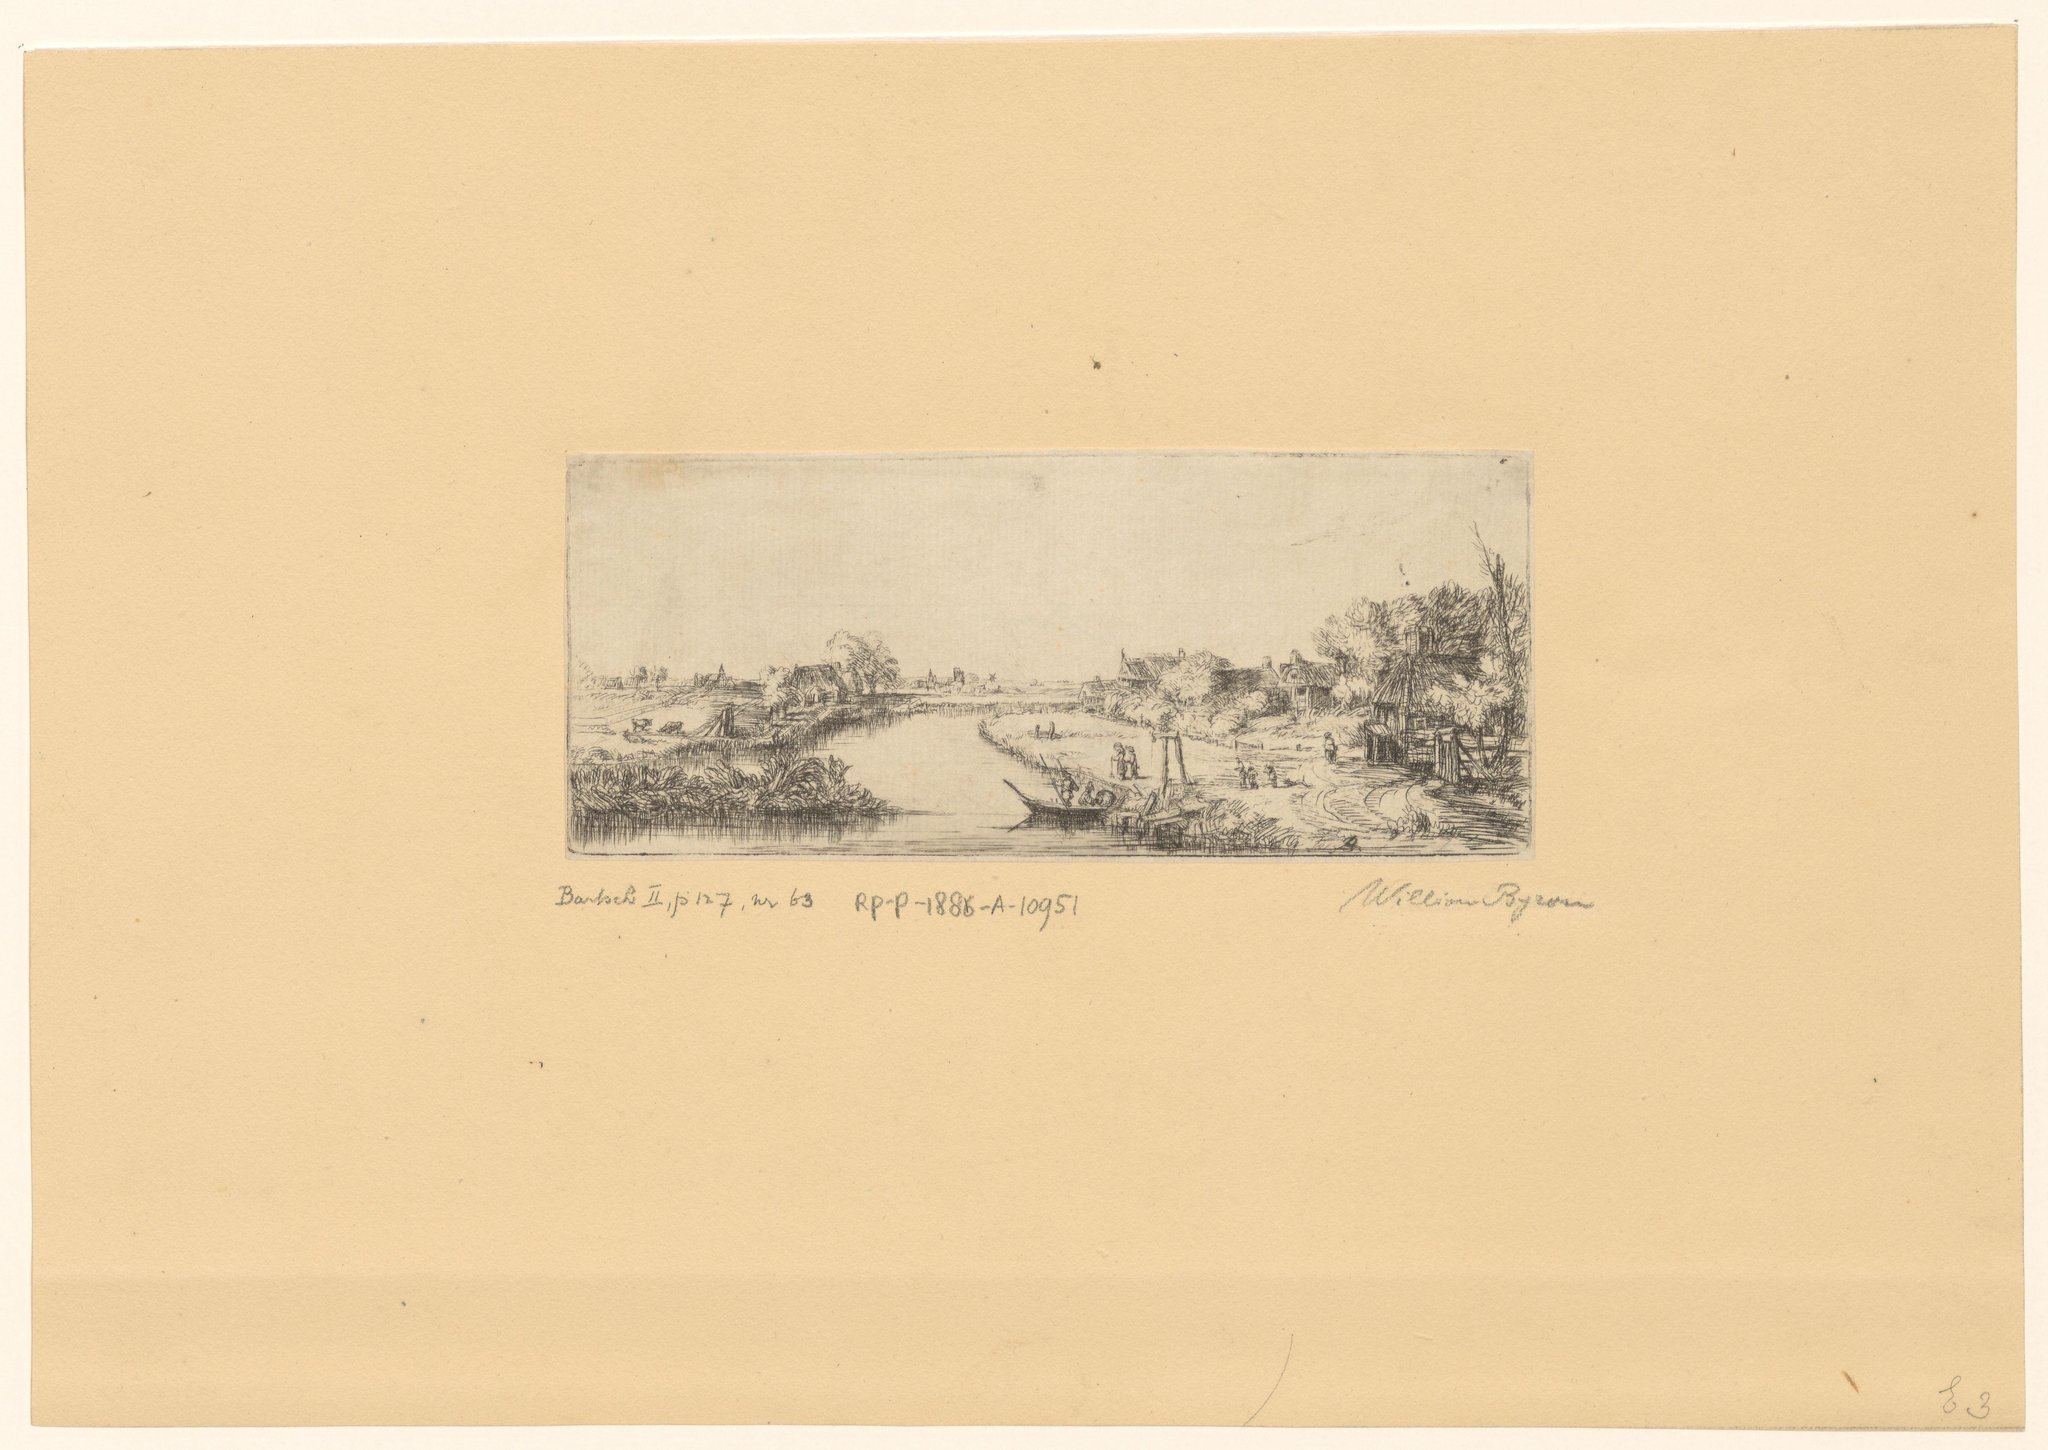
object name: print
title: Landschap met een dorp langs een rivier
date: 1777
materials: paper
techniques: etching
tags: village, river (+ landscape with figures, staffage)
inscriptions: collector's mark: Lugt 2228